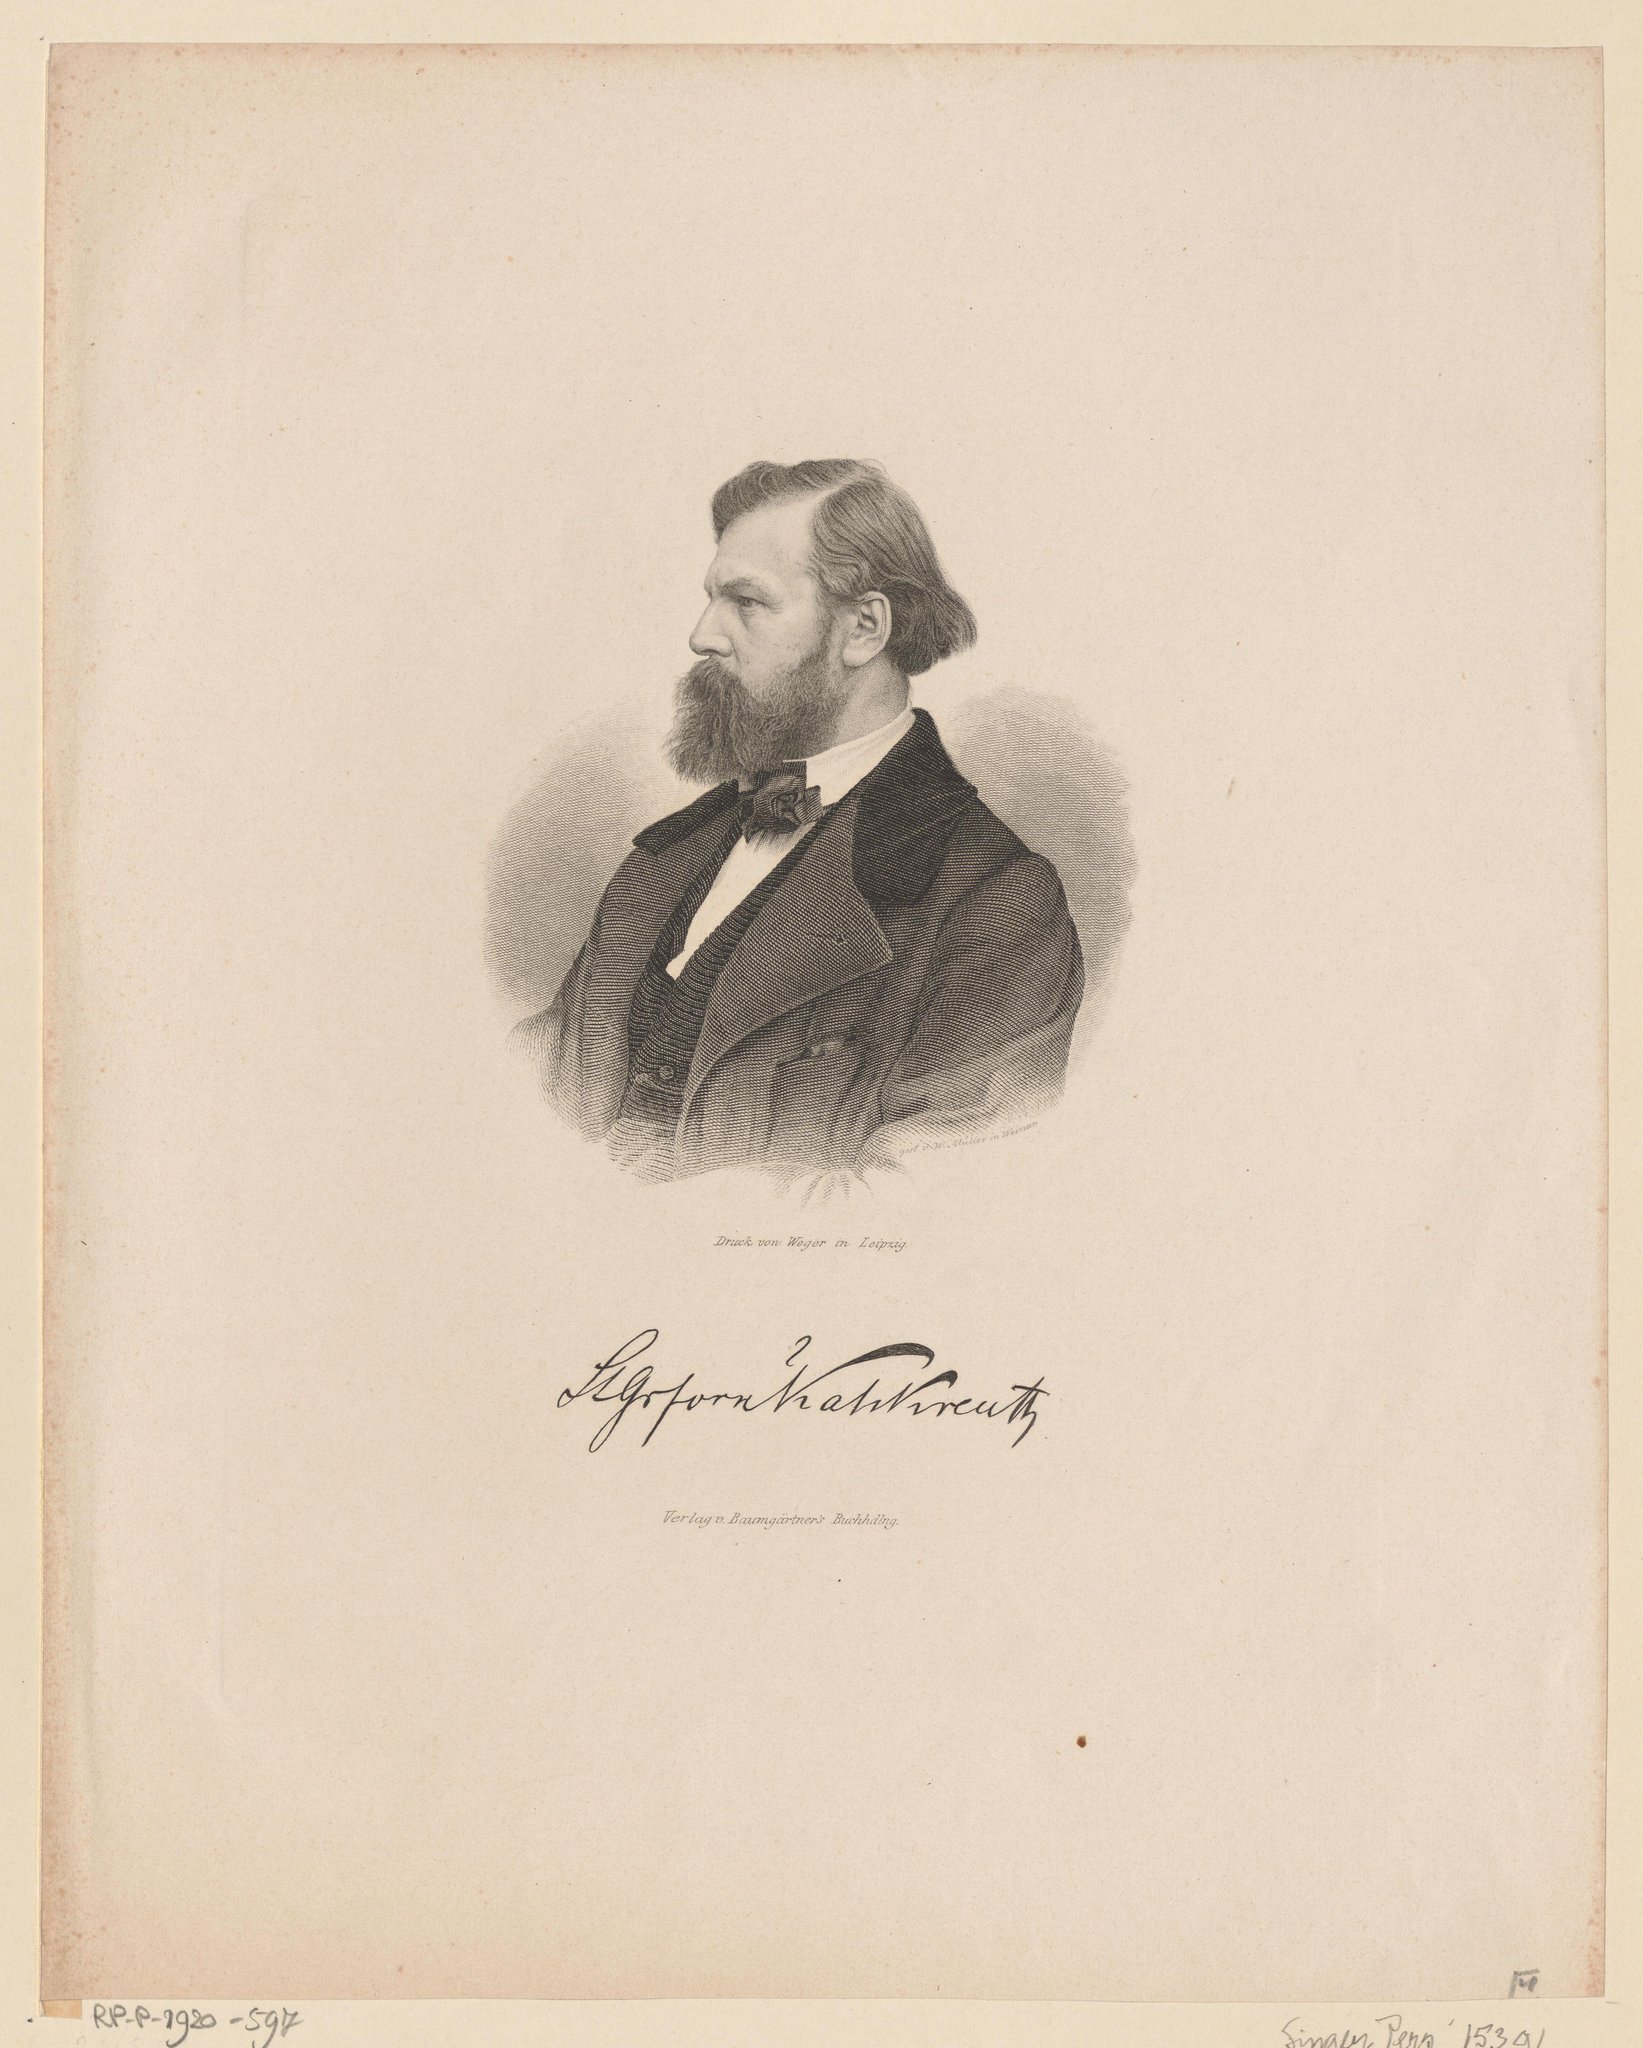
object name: print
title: Portret van Stanislaus Graf von Kalckreuth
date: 1850-1892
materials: paper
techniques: engraving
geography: leipzig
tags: poland, draughtsman, historical persons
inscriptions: collector's mark: Lugt 2228